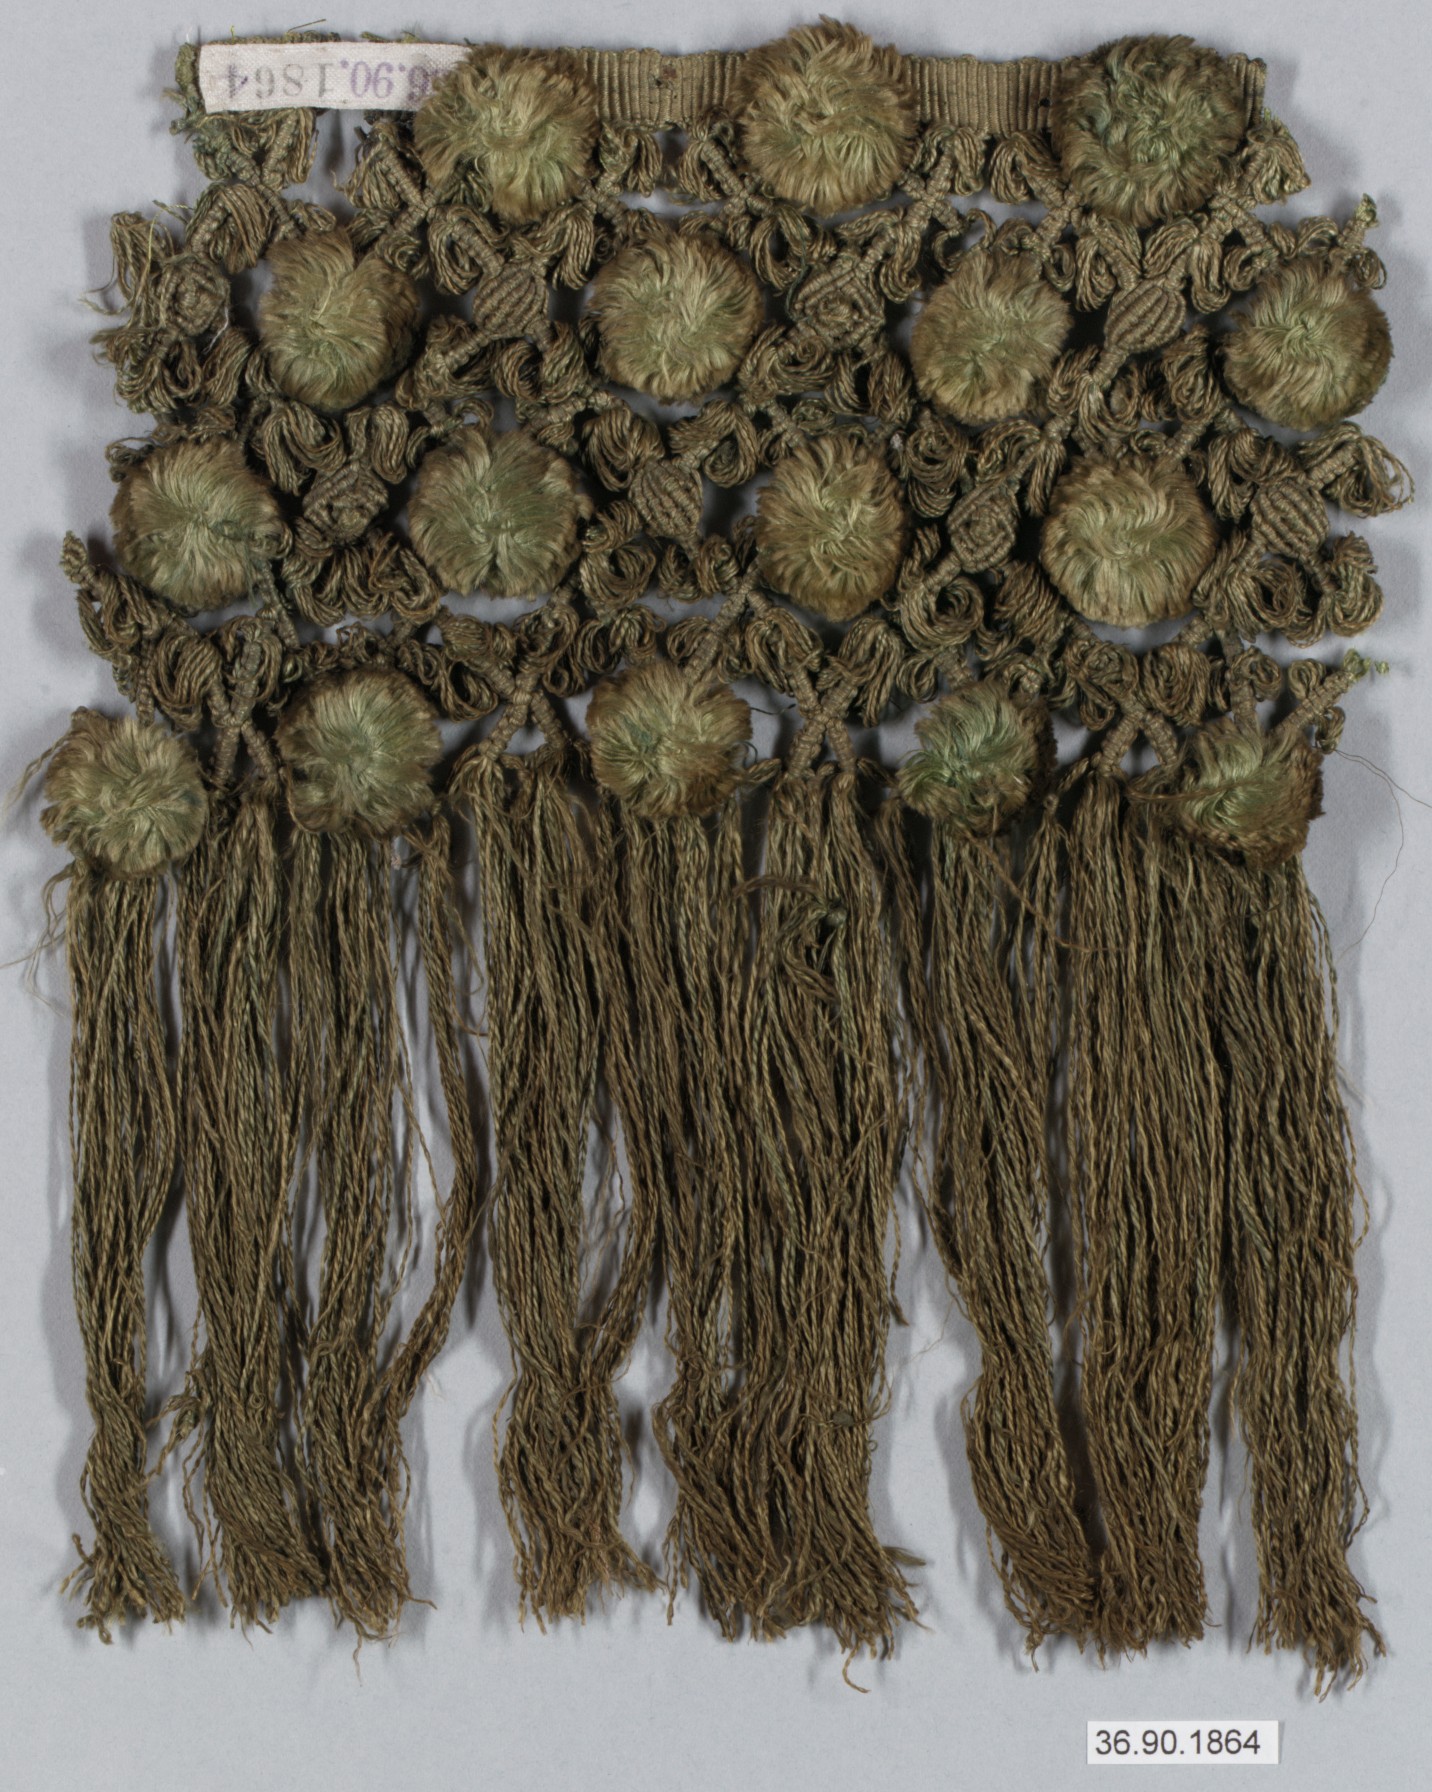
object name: fringe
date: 1801-1900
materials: silk